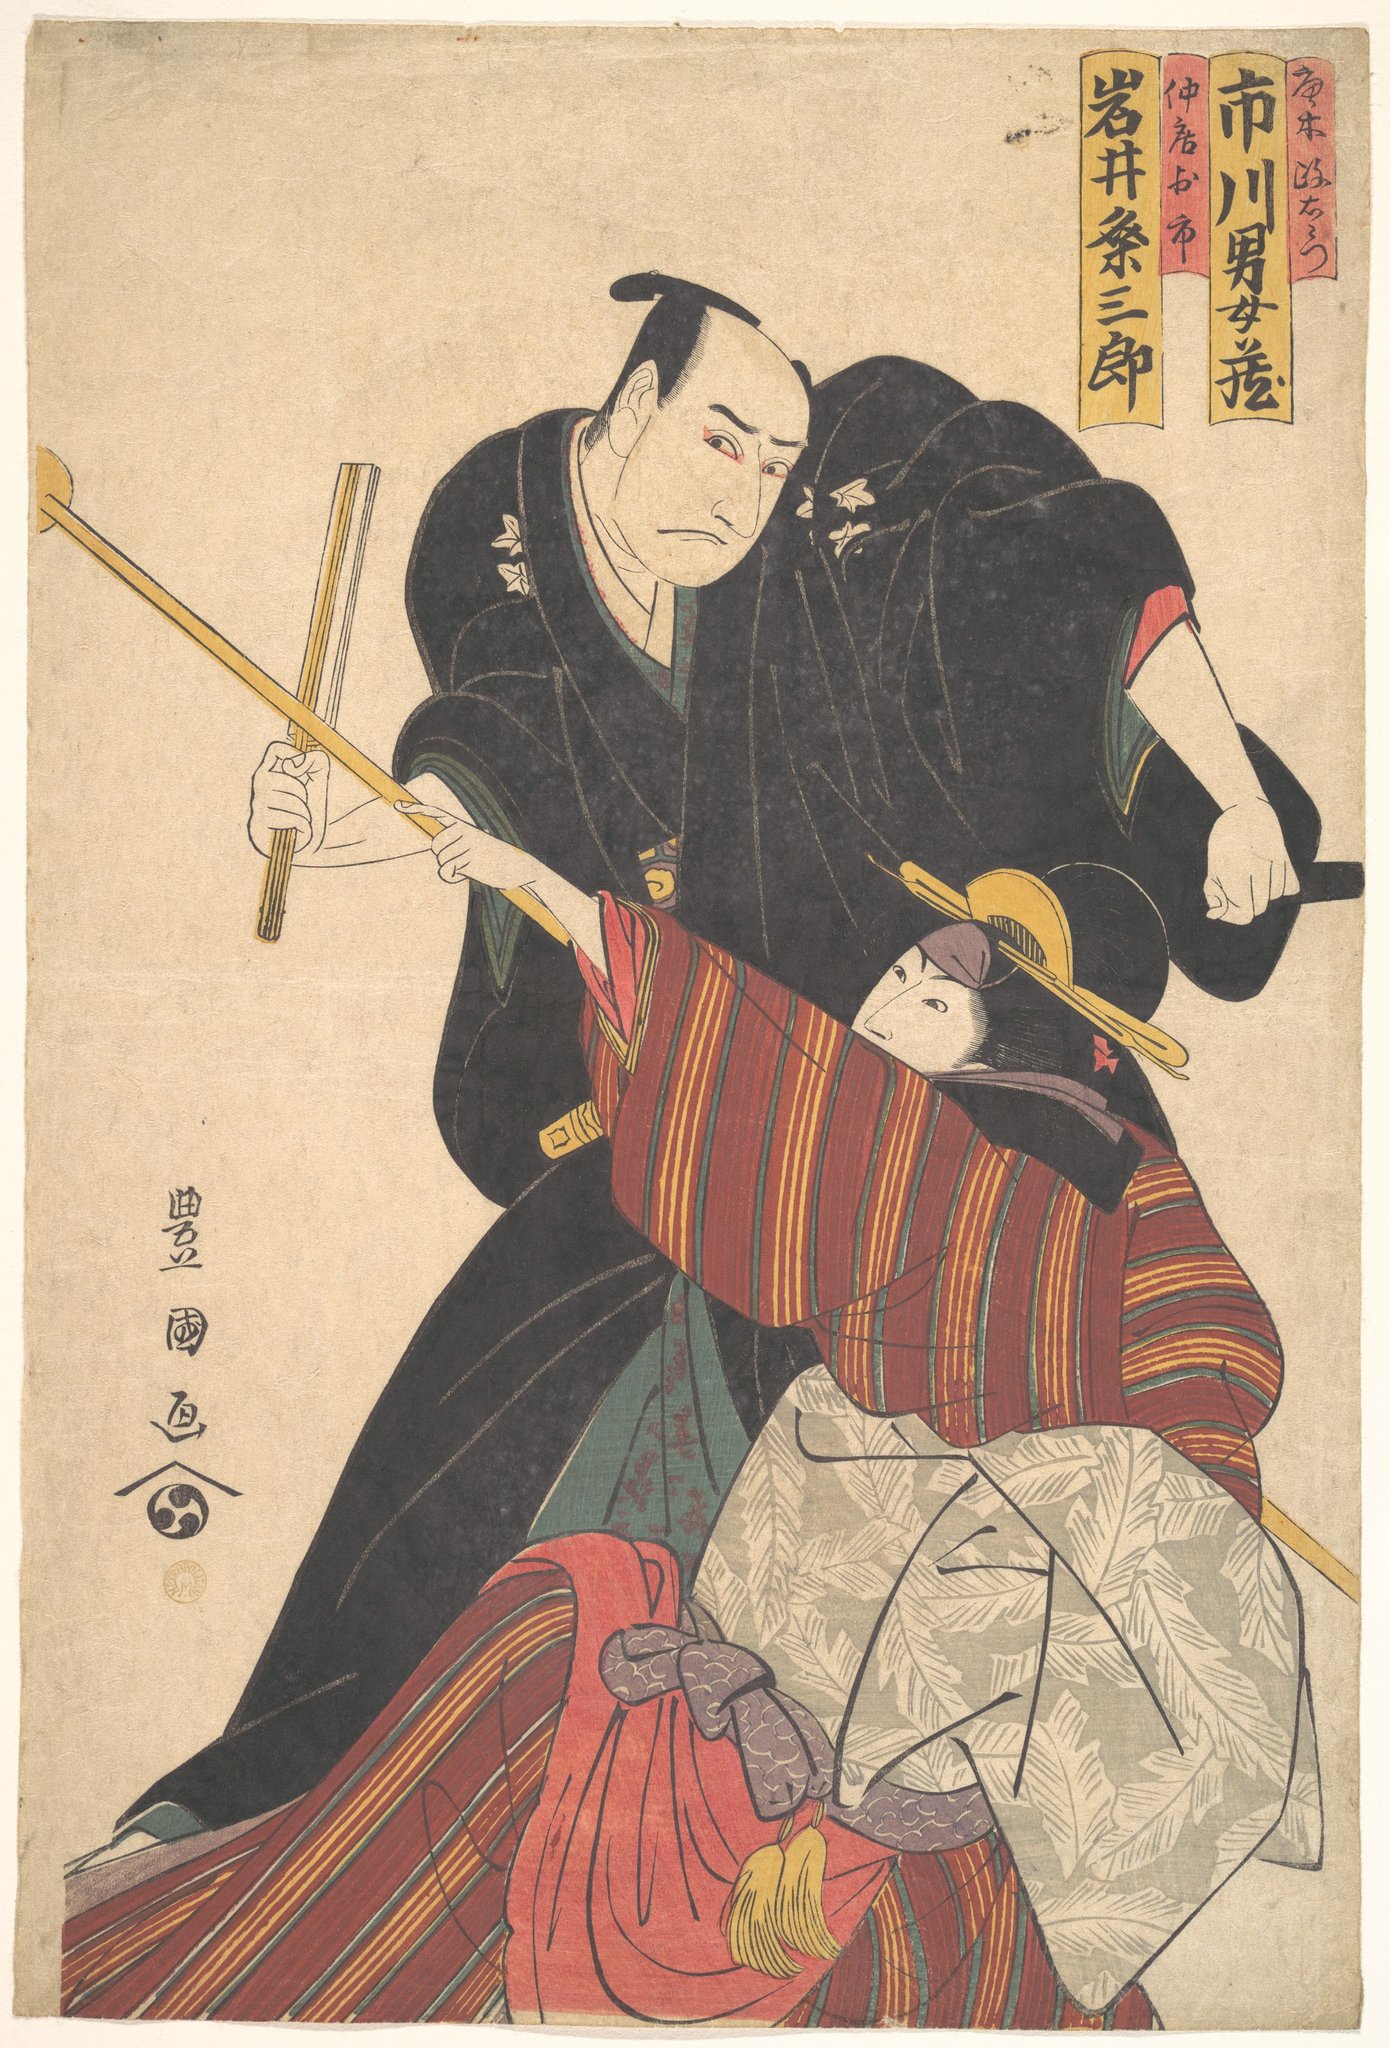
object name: woodblock print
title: Scene from a Drama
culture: japanese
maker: utagawa toyokuni i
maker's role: artist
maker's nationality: japanese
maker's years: 1769-1825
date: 1804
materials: ink, paper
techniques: woodblock print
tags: men,women,actors